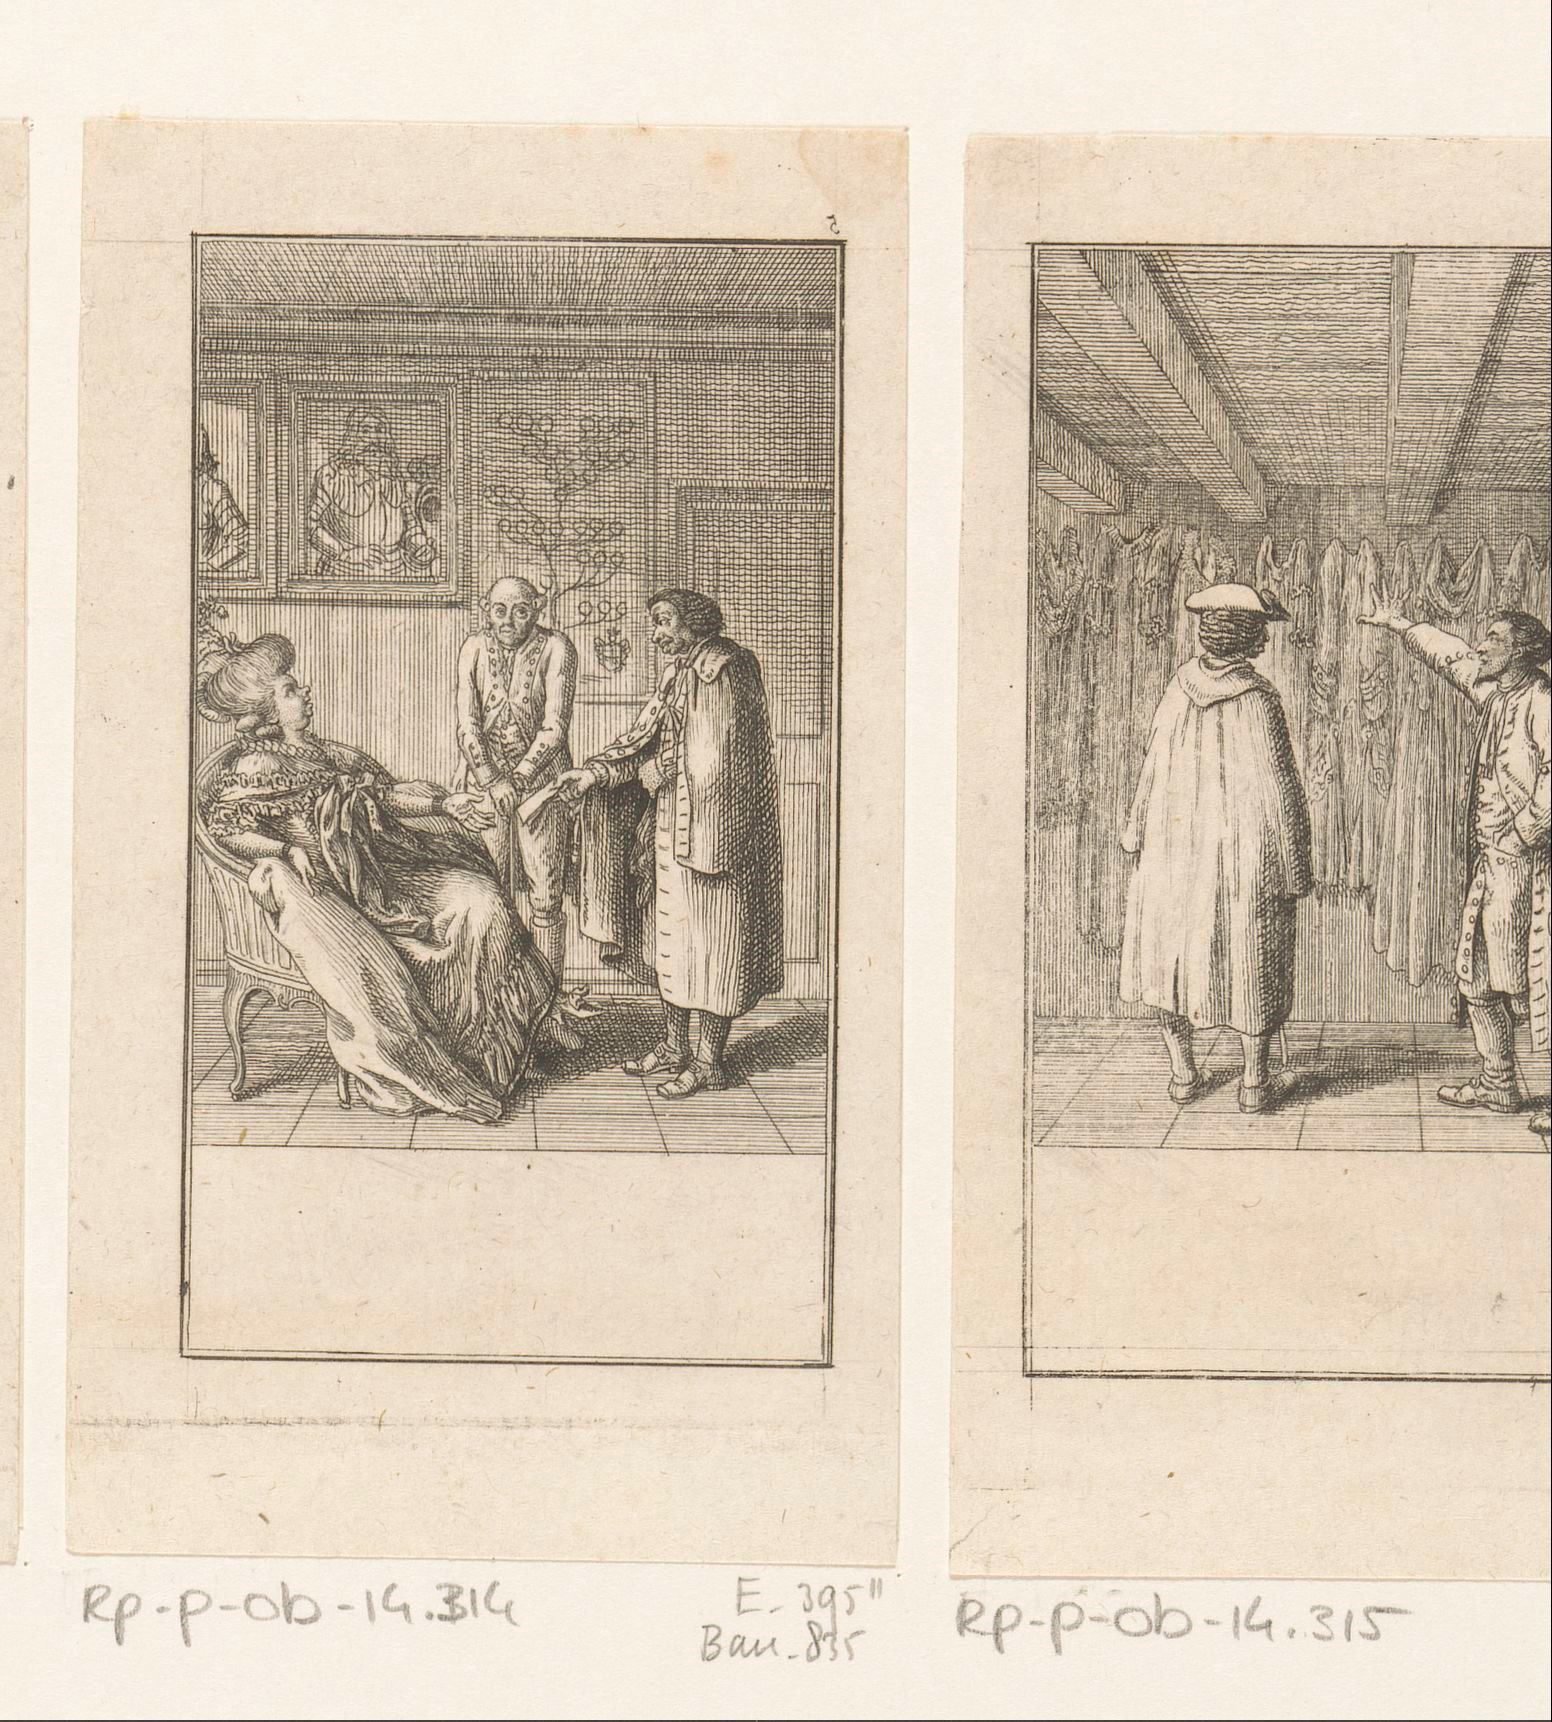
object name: print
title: Frau von Schmerling probeert Fritz tot de adel te laten toetreden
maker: daniel nikolaus chodowiecki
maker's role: draughtsman, print maker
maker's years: 1726-1801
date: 1781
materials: paper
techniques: etching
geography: berlin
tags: berlin, family lineage, pedigree, genealogical tree or table, conversation, dialogue; conversation piece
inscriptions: collector's mark: Lugt 2228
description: Vervaardigd voor G. F. W. Grossmann's 'Nicht mehr als sechs Schüsseln'. Een latere staat gebruikt in: Königl. Grossbr. Genealogischer Kalender auf das Jahr 1782. Lauenburger: J.G. Berenberg, 1782.